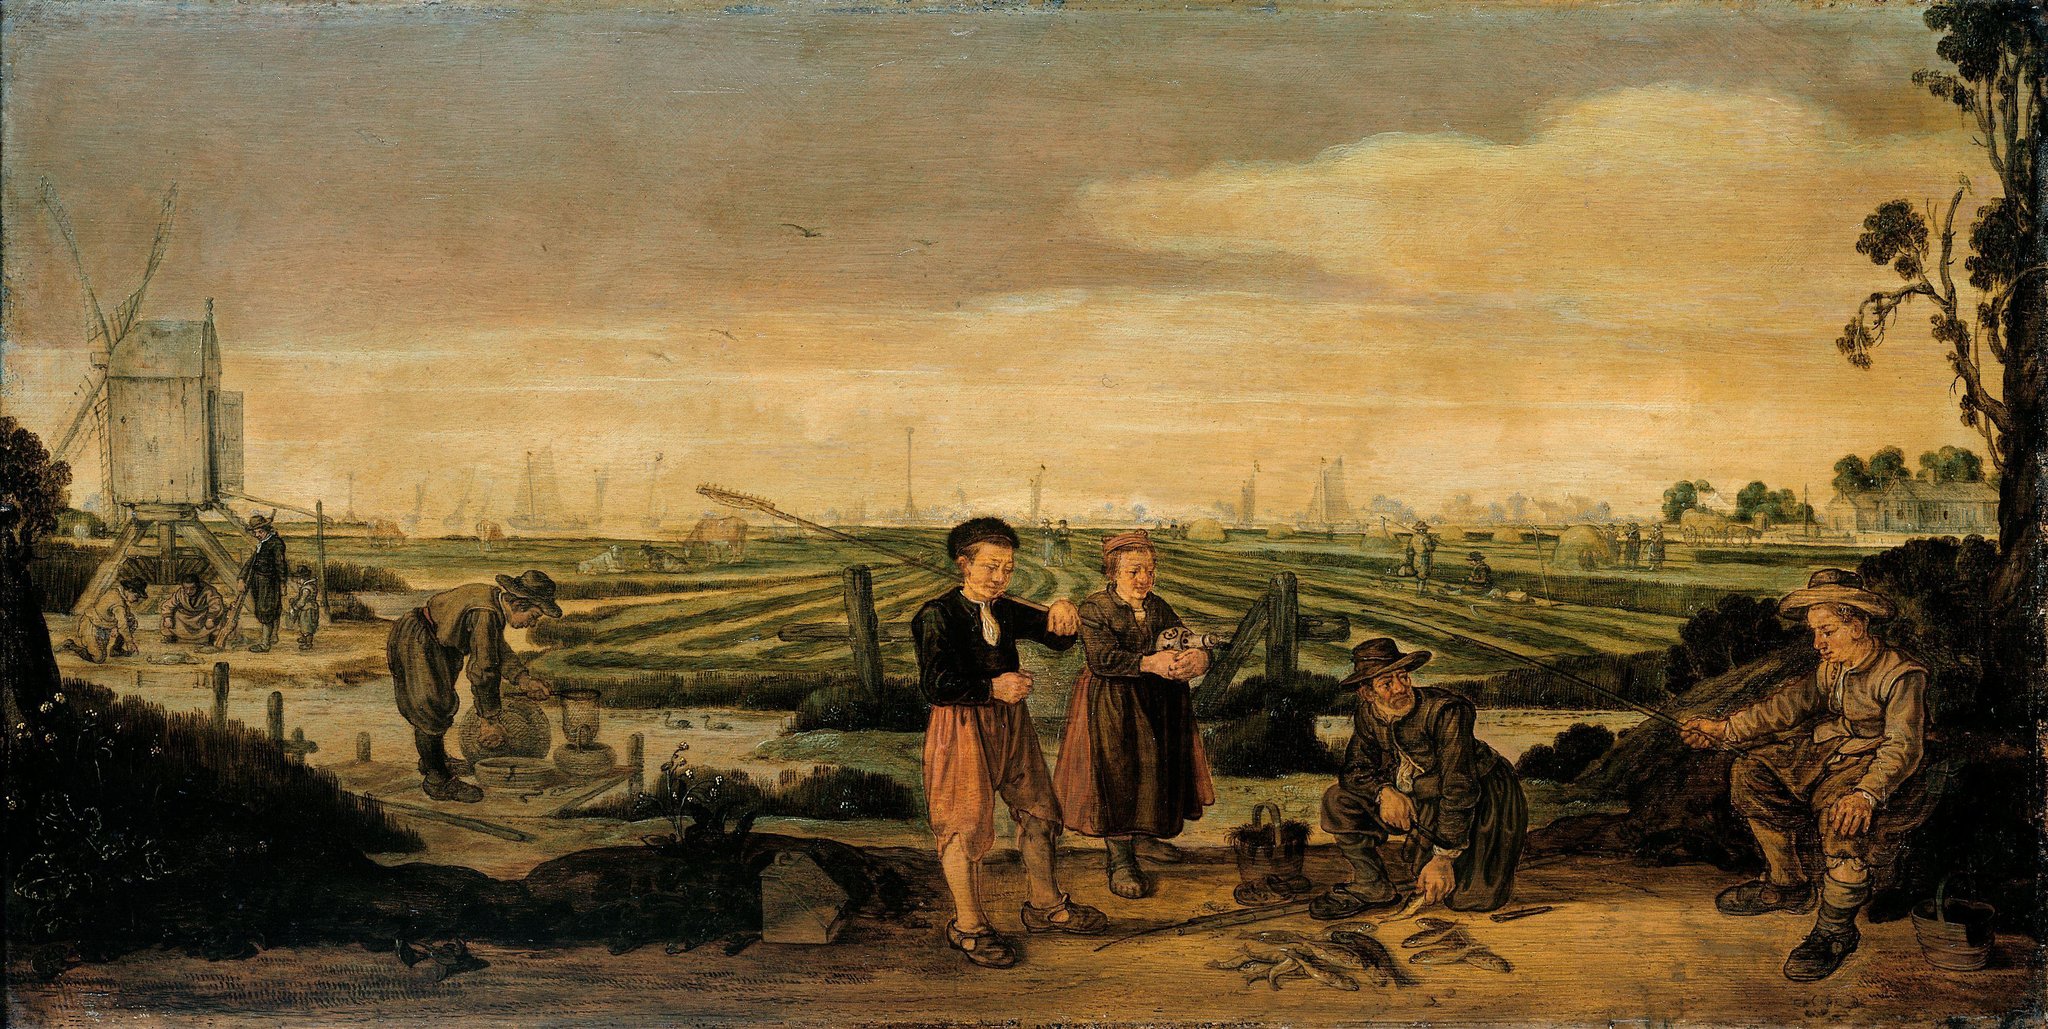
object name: painting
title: Fishermen and Farmers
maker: arent arentsz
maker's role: draughtsman, painter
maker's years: 1585-1631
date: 1625-1630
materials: oil, panel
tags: commercial fishery, farmers, cultivated land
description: Fishermen and farmers, by Arent Arentsz called Cabel, first half 17th century. Because the population increased demand for food rose. Arable and livestock farming flourished. Large investments were made in agriculture. To obtain more land, massive areas still under water were drained dry to create polders. Agricultural products were not just for the Dutch market. Meat, cheese, butter, fruit, beer and tobacco were all exported in large quantities.